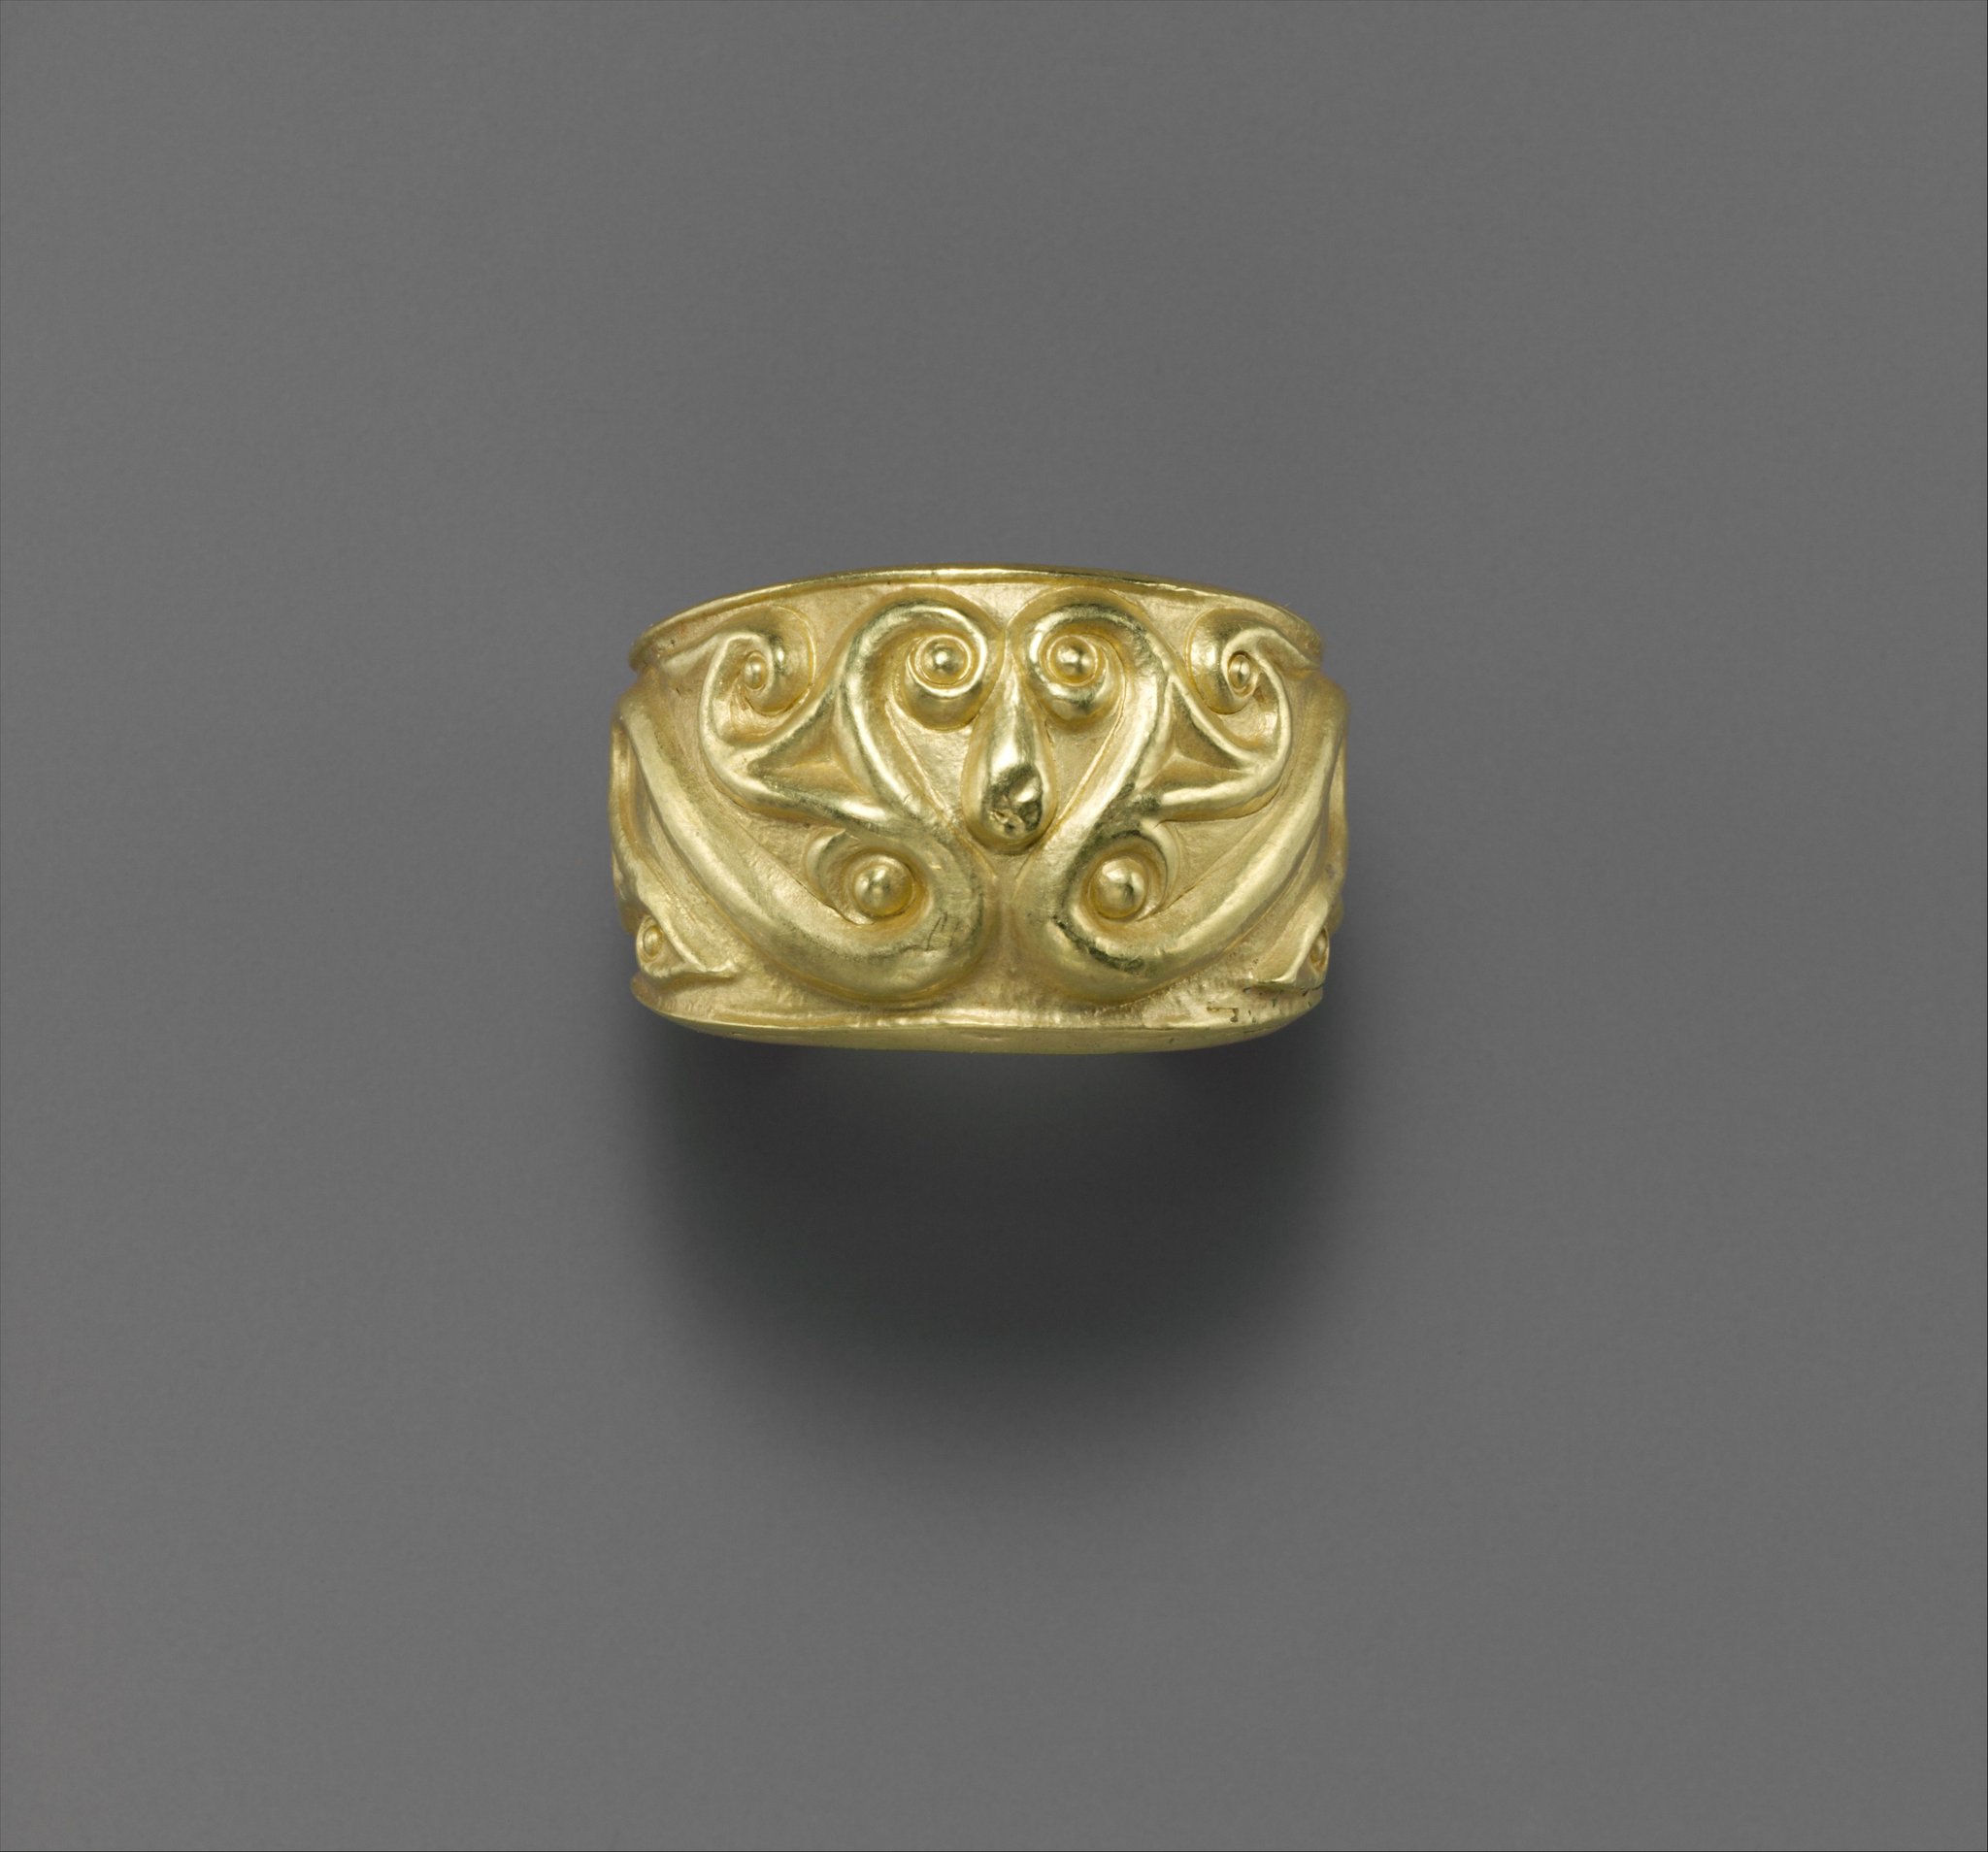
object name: ring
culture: celtic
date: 401-400 BCE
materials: gold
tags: rings